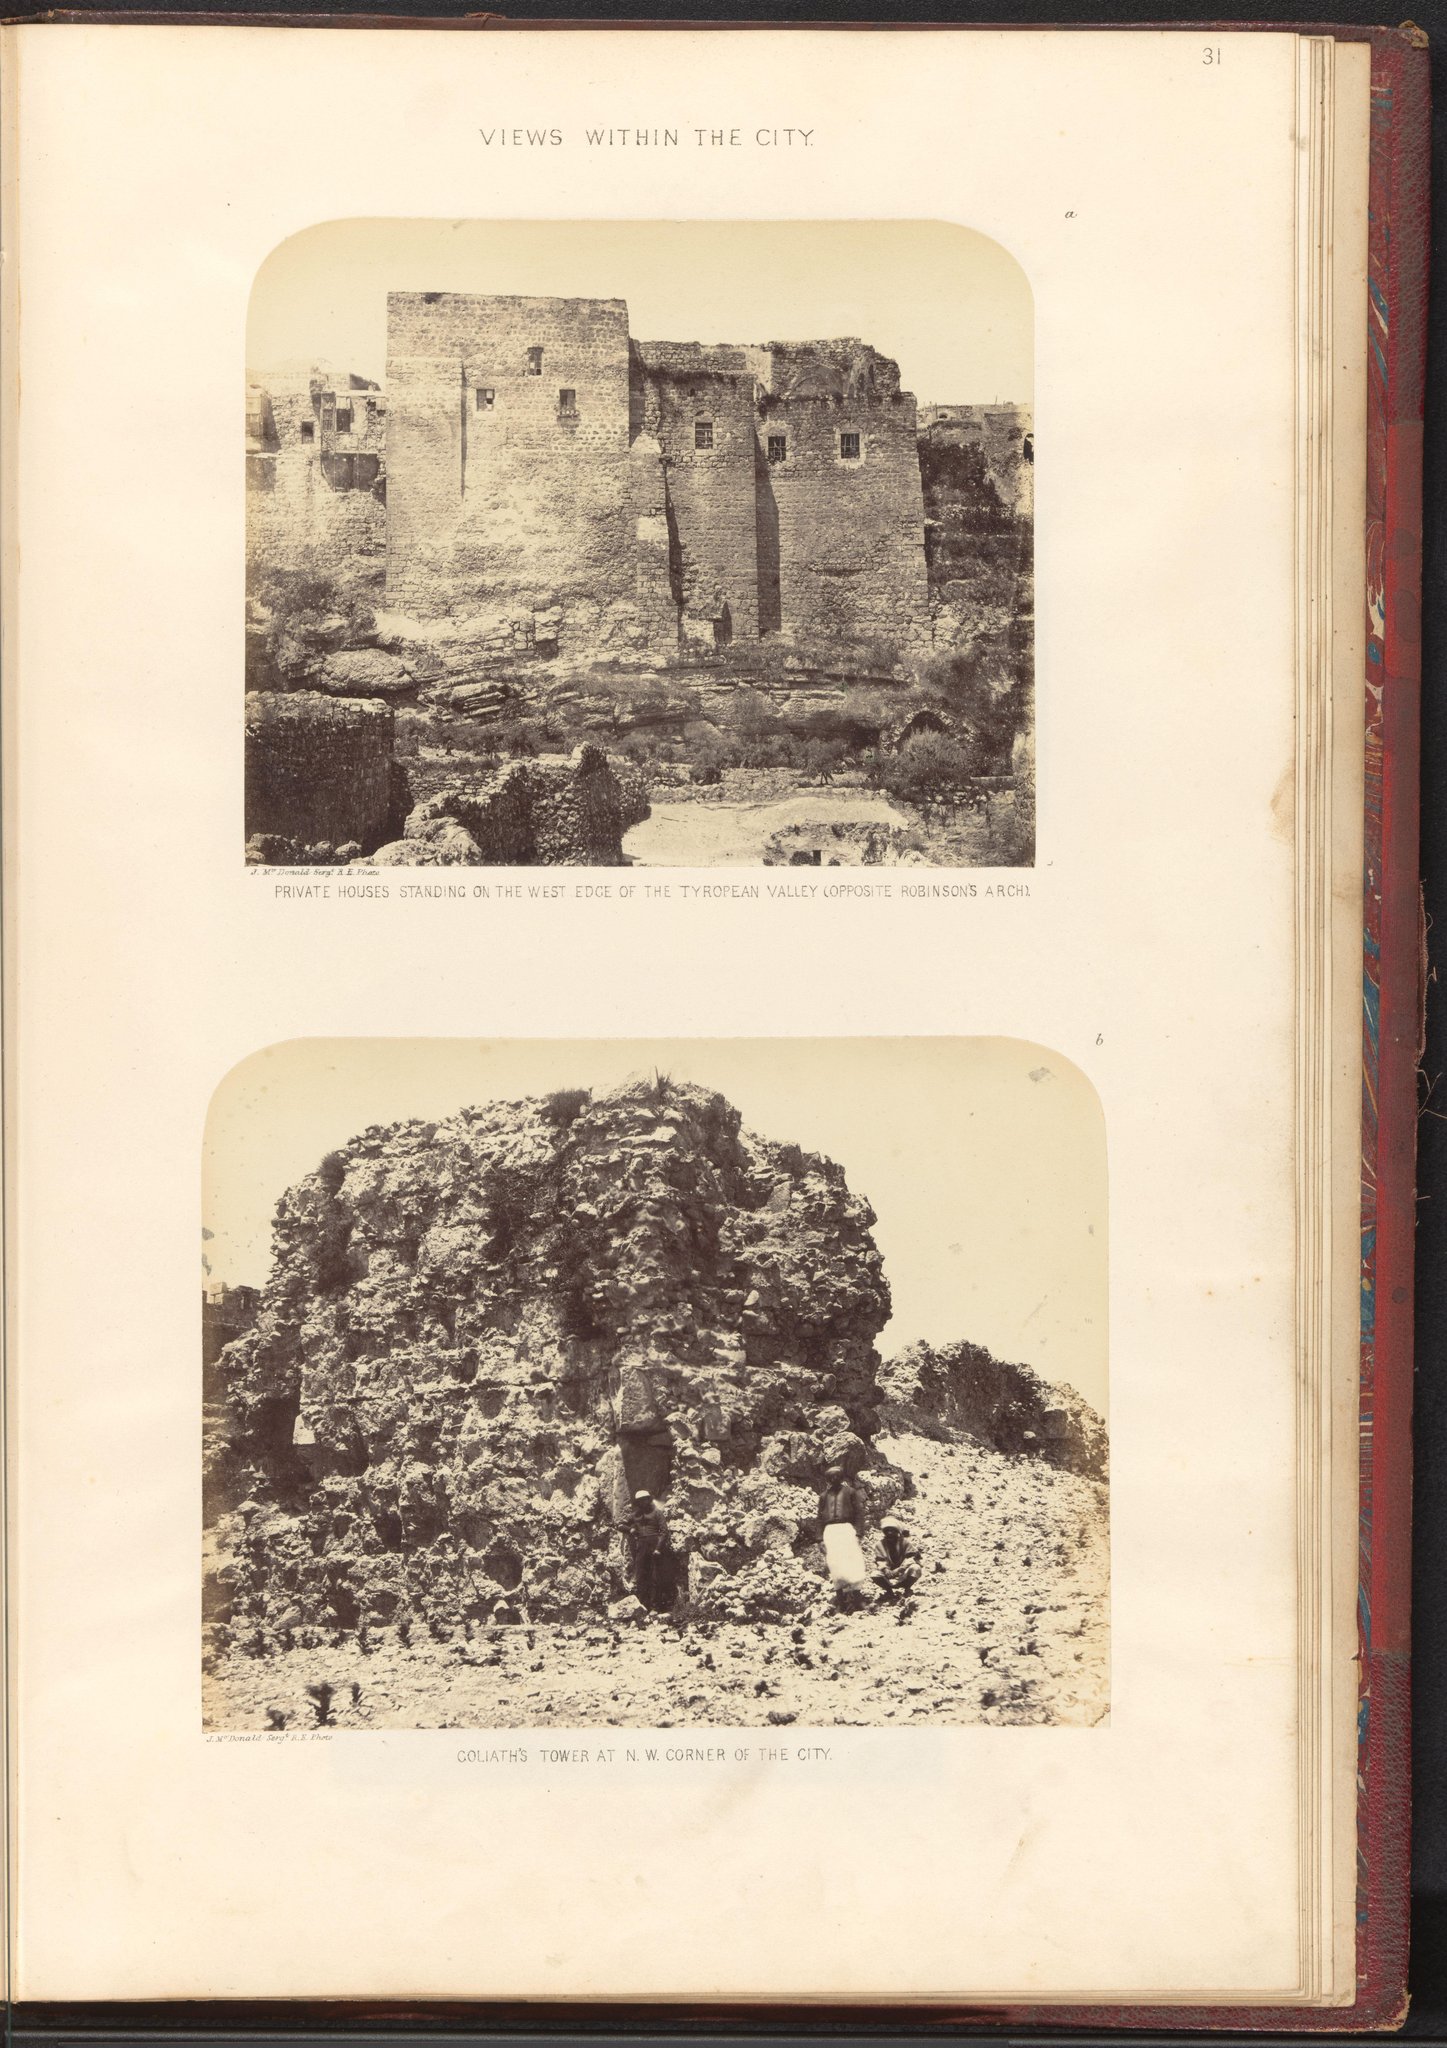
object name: page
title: Private Houses Standing on the West Edge of the Tyropean Valley (opposite Robinson's Arch)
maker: james mcdonald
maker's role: fotograaf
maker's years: 1822-1885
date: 1860-1865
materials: paper, photographic support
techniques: albumen print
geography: jerusalem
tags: ruin of a building ~ architecture, housing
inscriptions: inscription: ‘b’, inscription: ‘a’